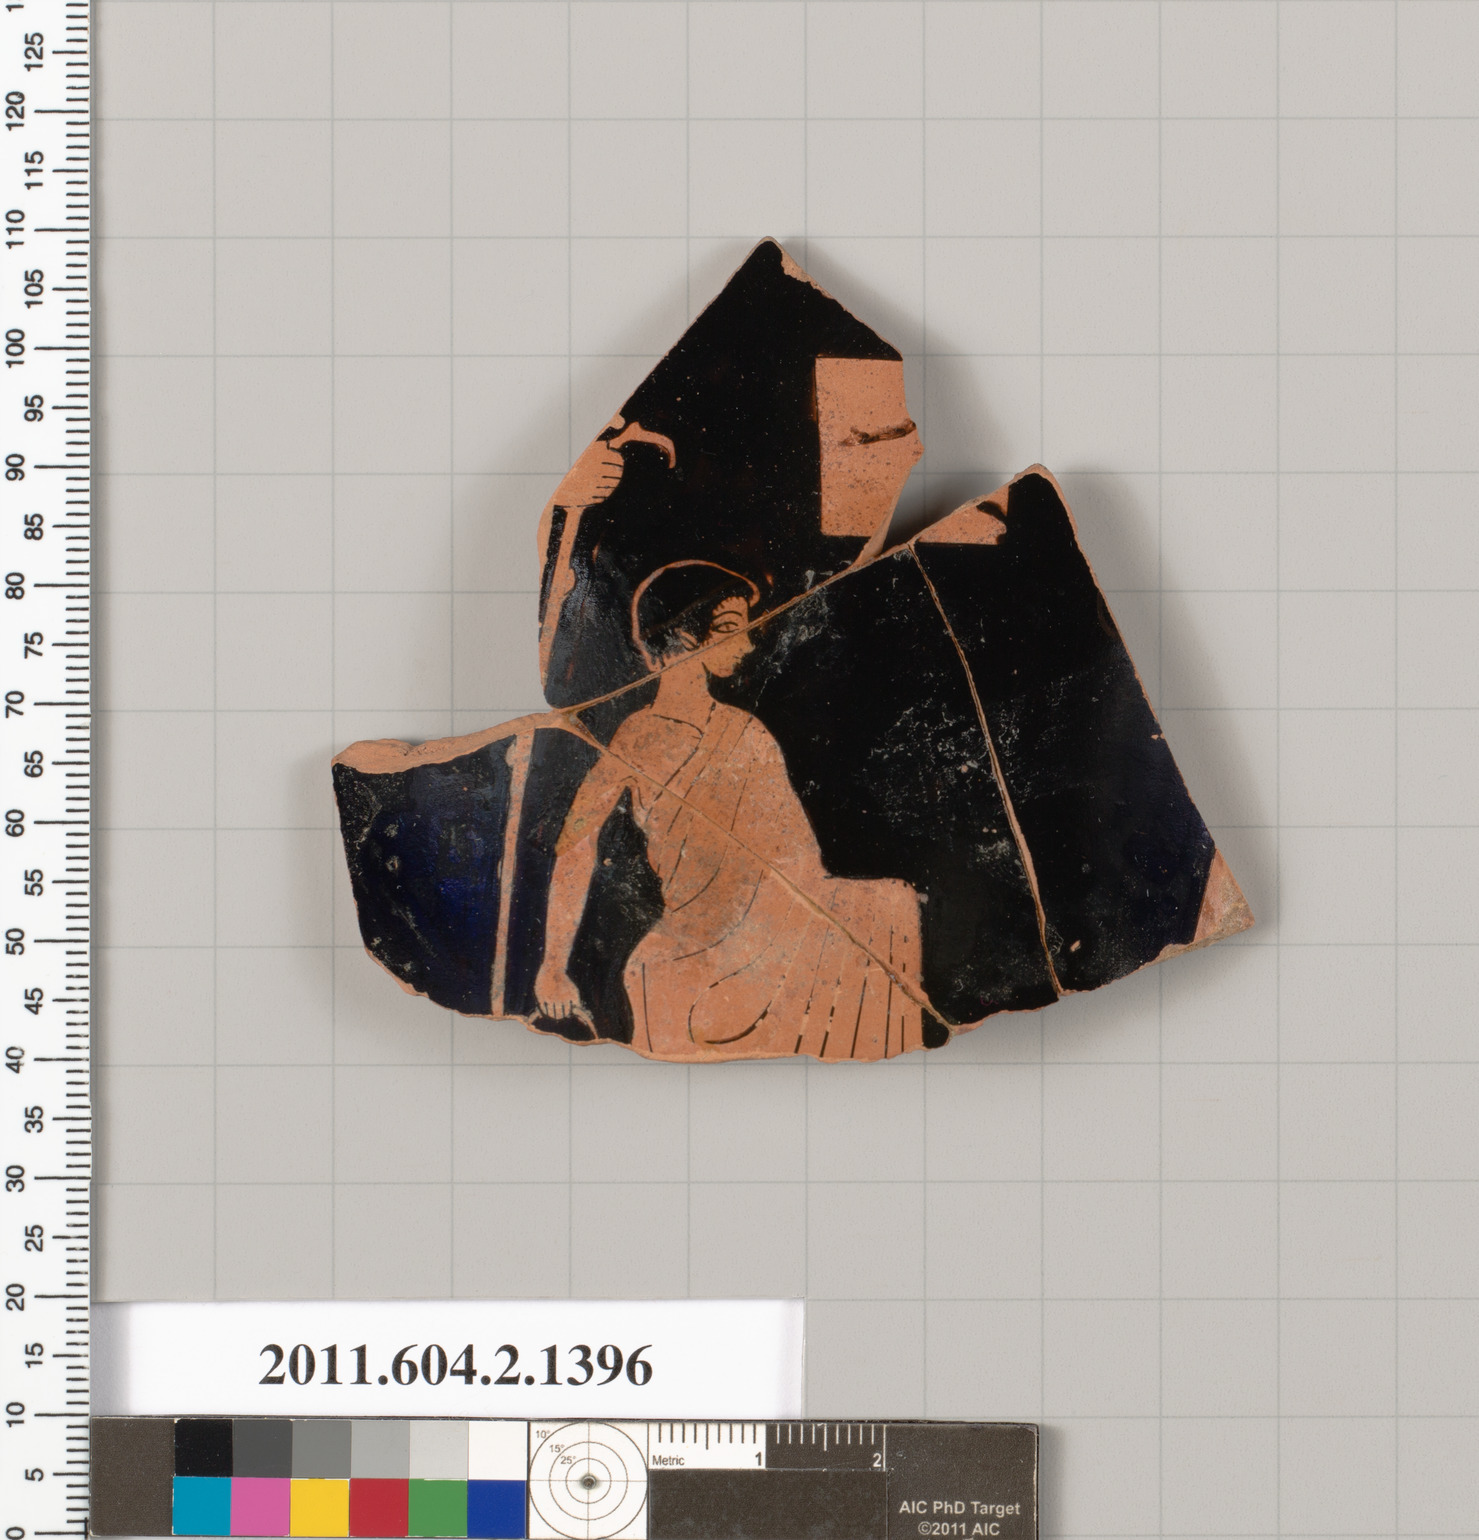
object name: skyphos fragment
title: Terracotta fragment of a skyphos (deep drinking cup)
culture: greek, attic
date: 467-435 BCE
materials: terracotta